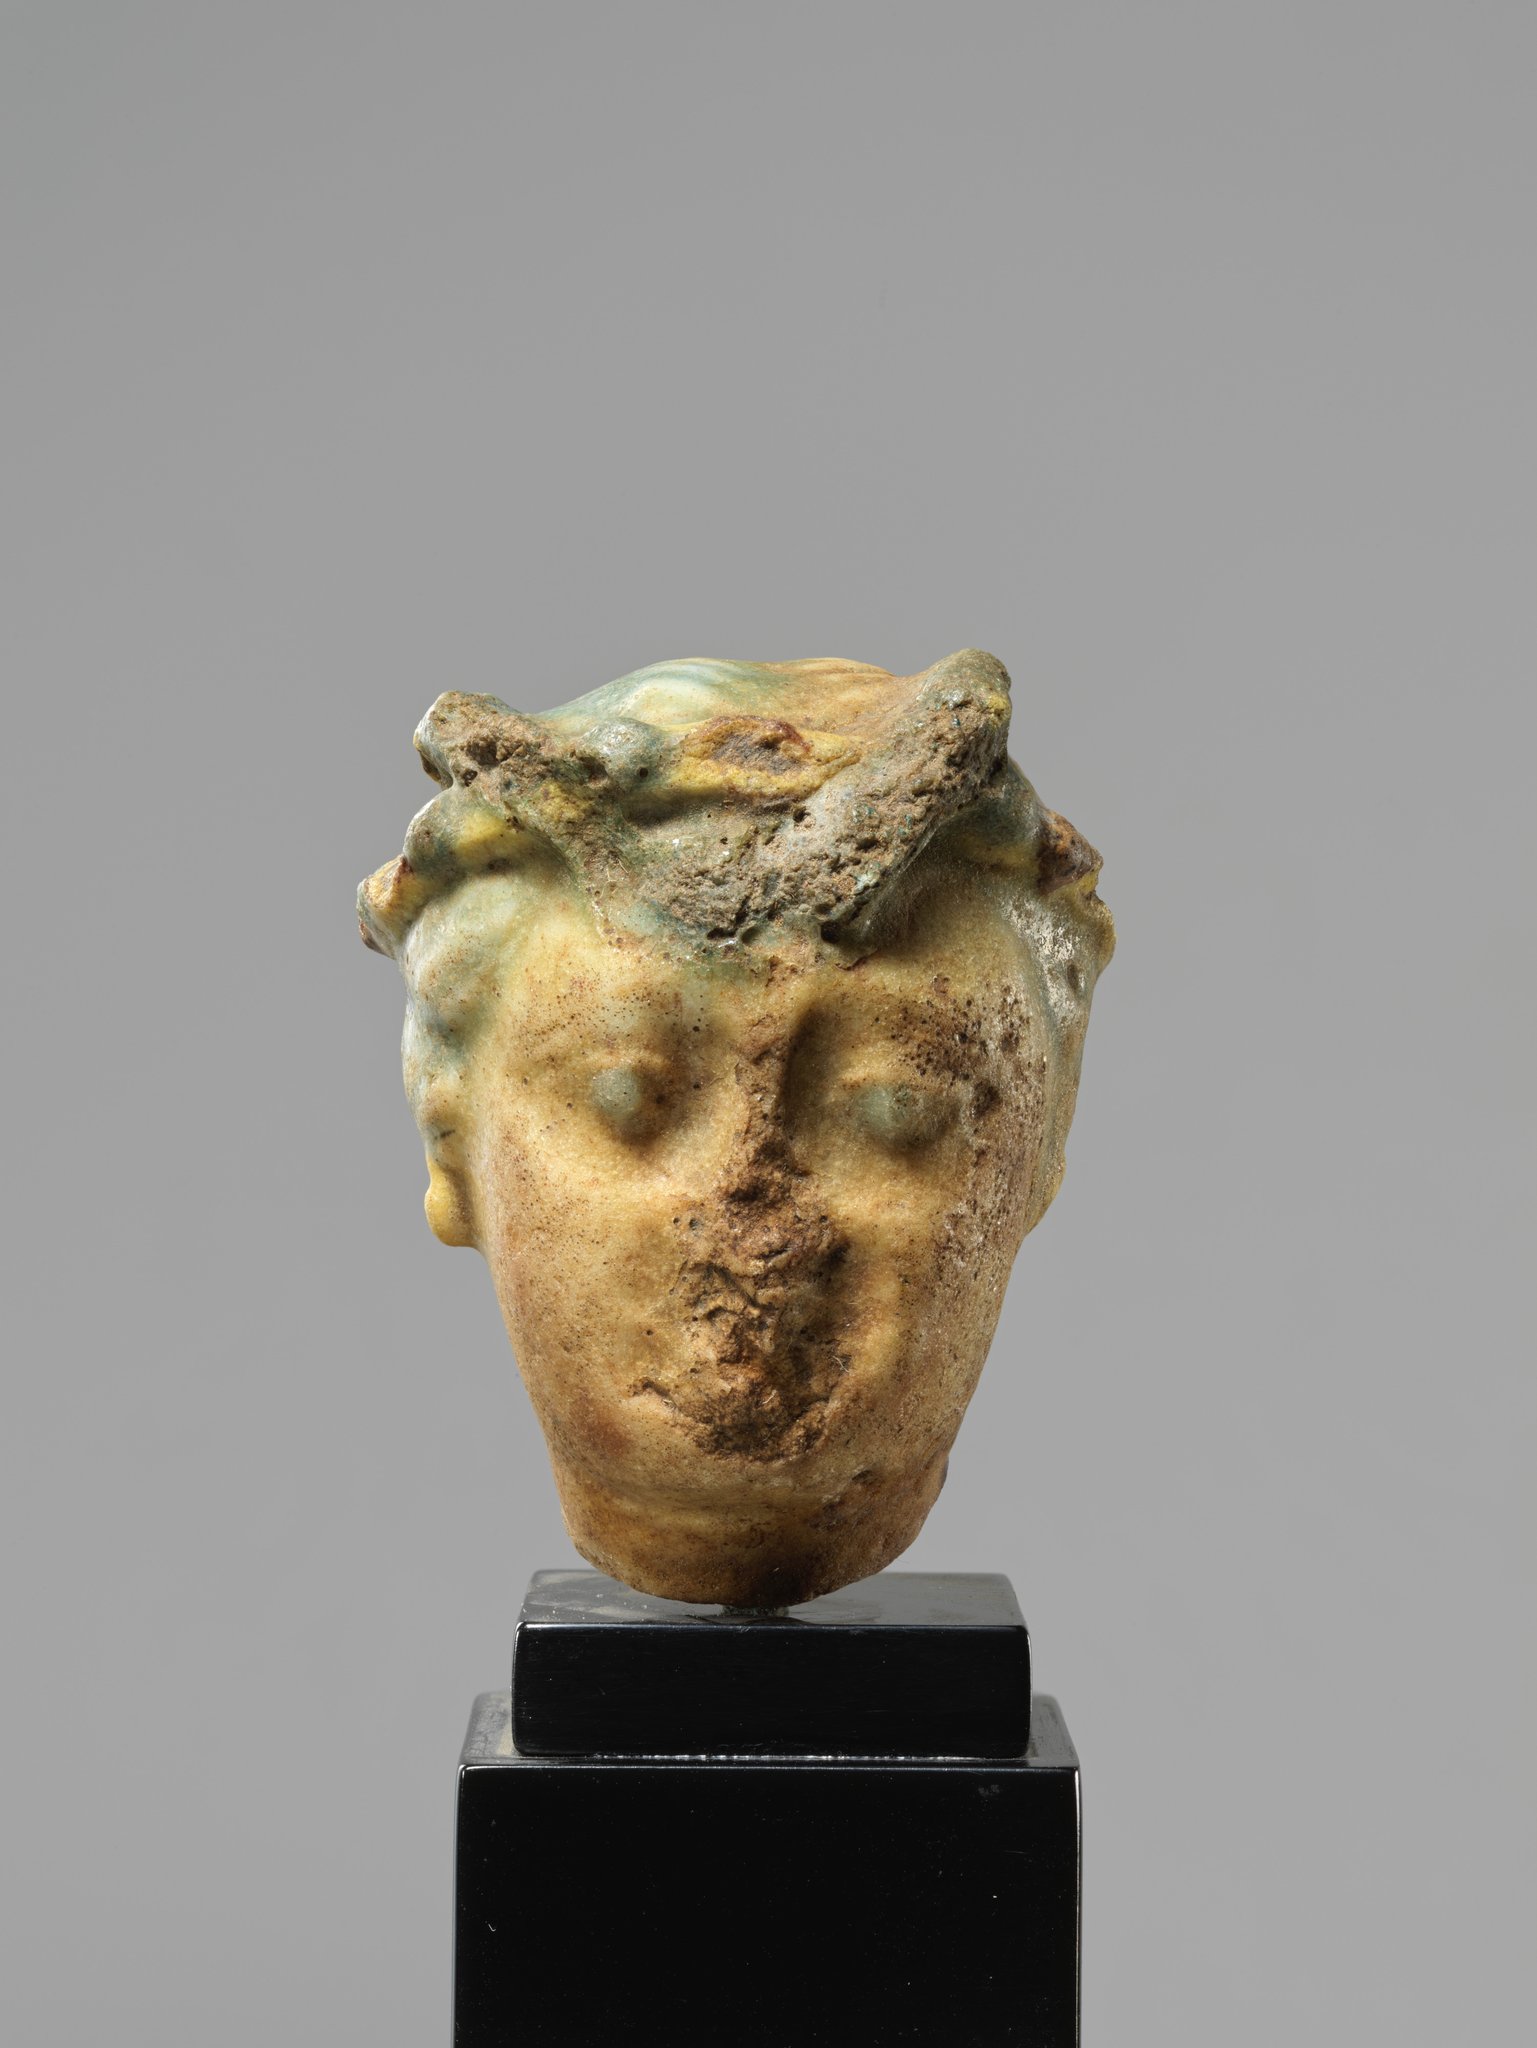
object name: head of a ptolemaic queen, berenike ii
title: Head of a Ptolemaic Queen, Possibly Berenike II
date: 246-222 BCE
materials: faience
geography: egypt